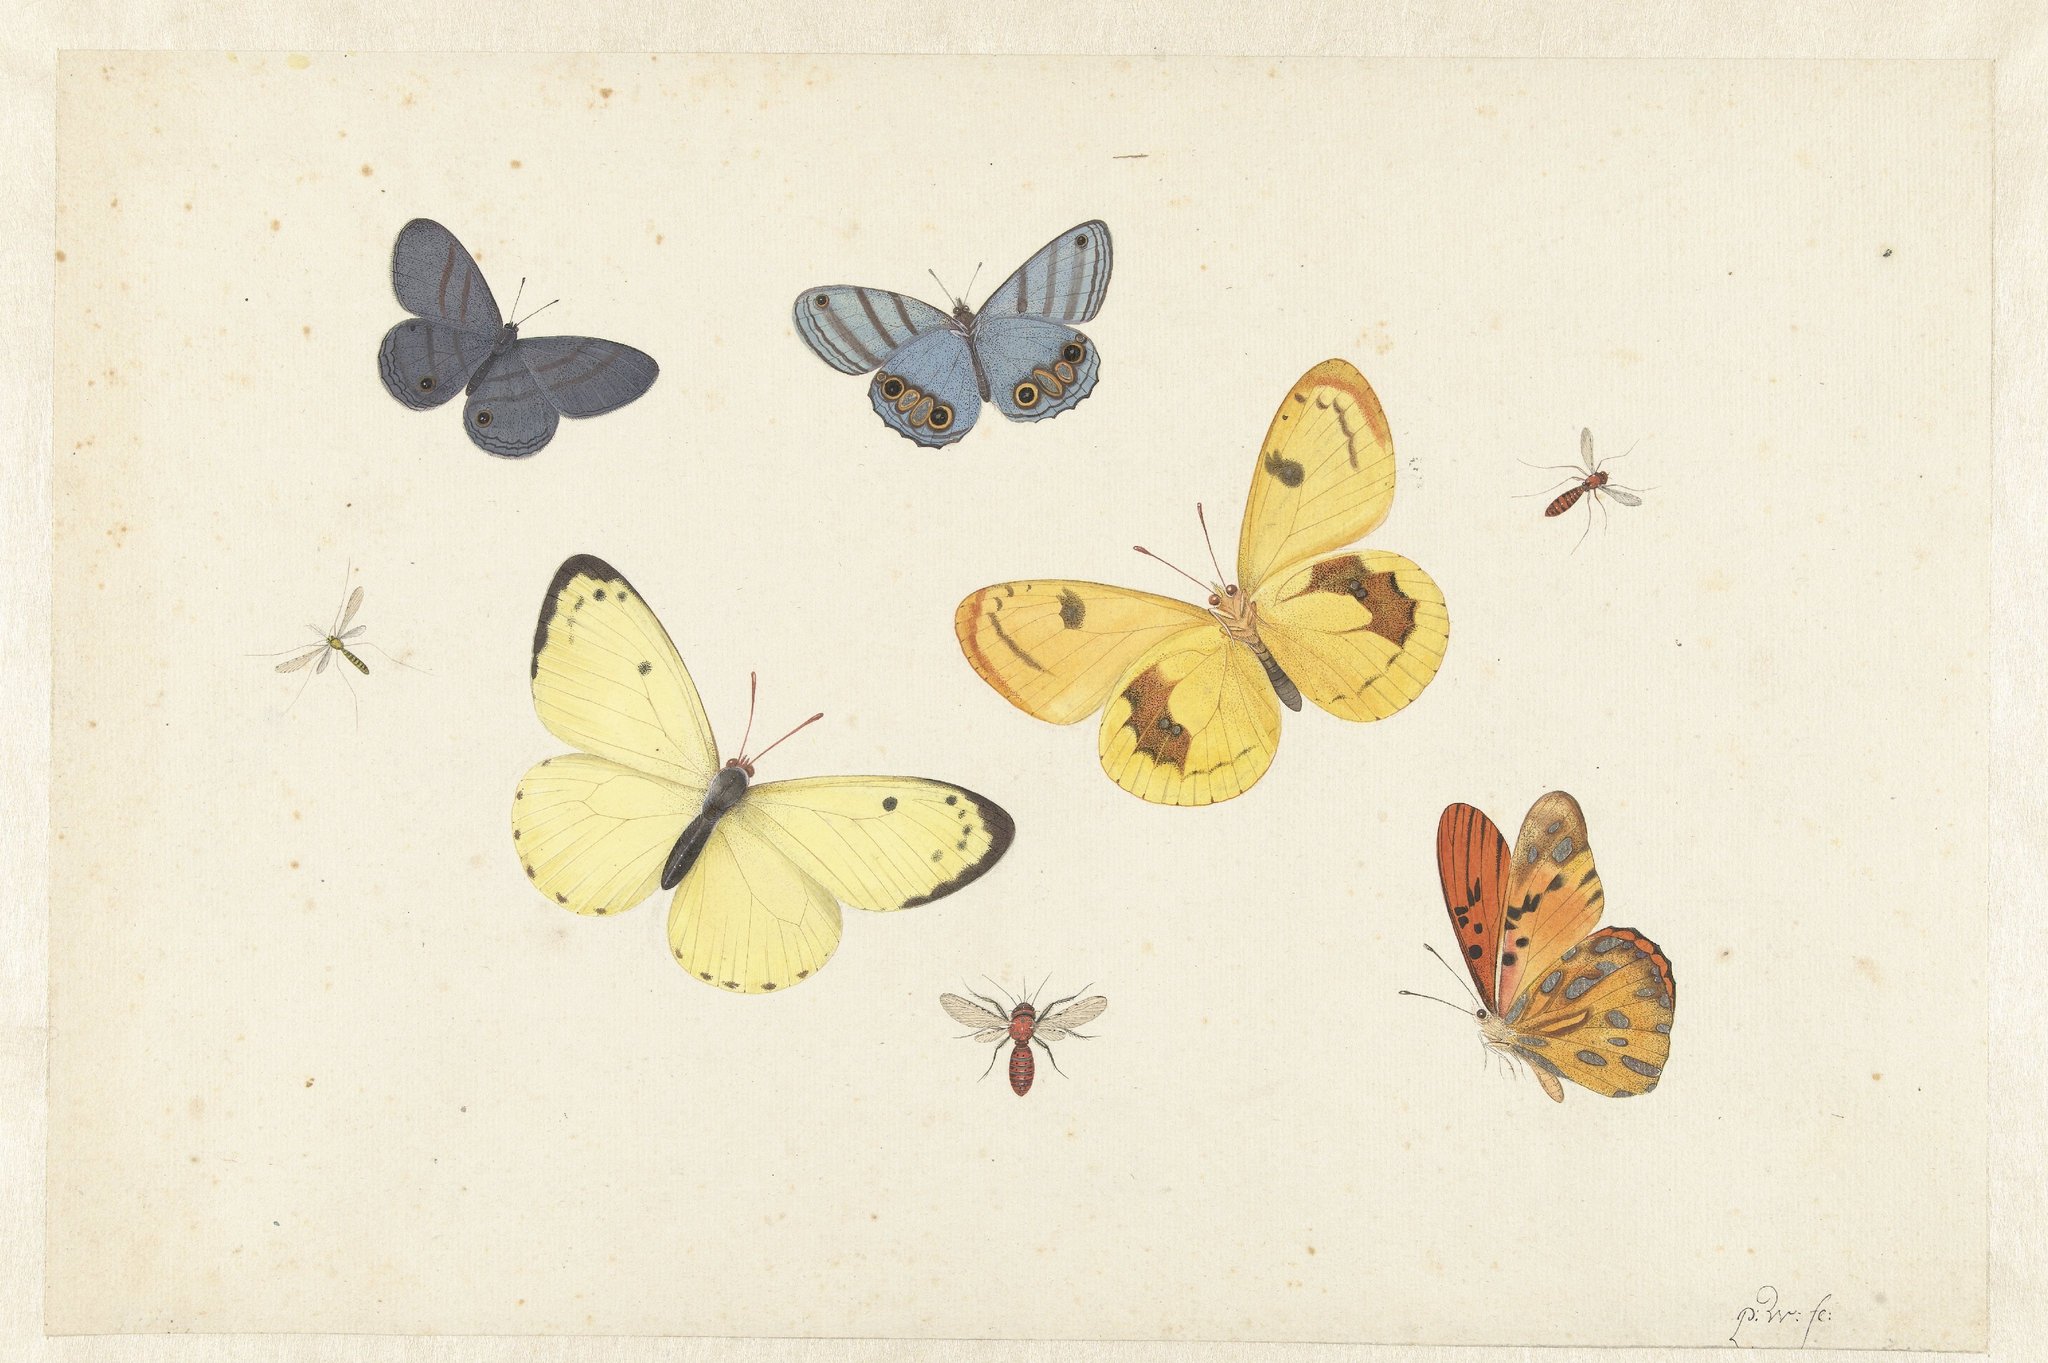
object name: watercolor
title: Sheet with Five Butterflies, a Wasp and Two Flies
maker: pieter withoos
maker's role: draughtsman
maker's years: 1654-1693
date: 1680-1692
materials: paper, watercolor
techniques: brush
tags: insects: wasp, insects: butterfly, insects: fly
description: Drawings of butterflies like this sheet by Pieter Withoos of Amersfoort are devoid of any scientific pretensions. The artist may not have even known the names of the mounted specimens he was representing. He was more interested in creating a beautiful composition and alternating contrasting coloured insects, such as the blue and yellow-orange butterflies in this drawing.